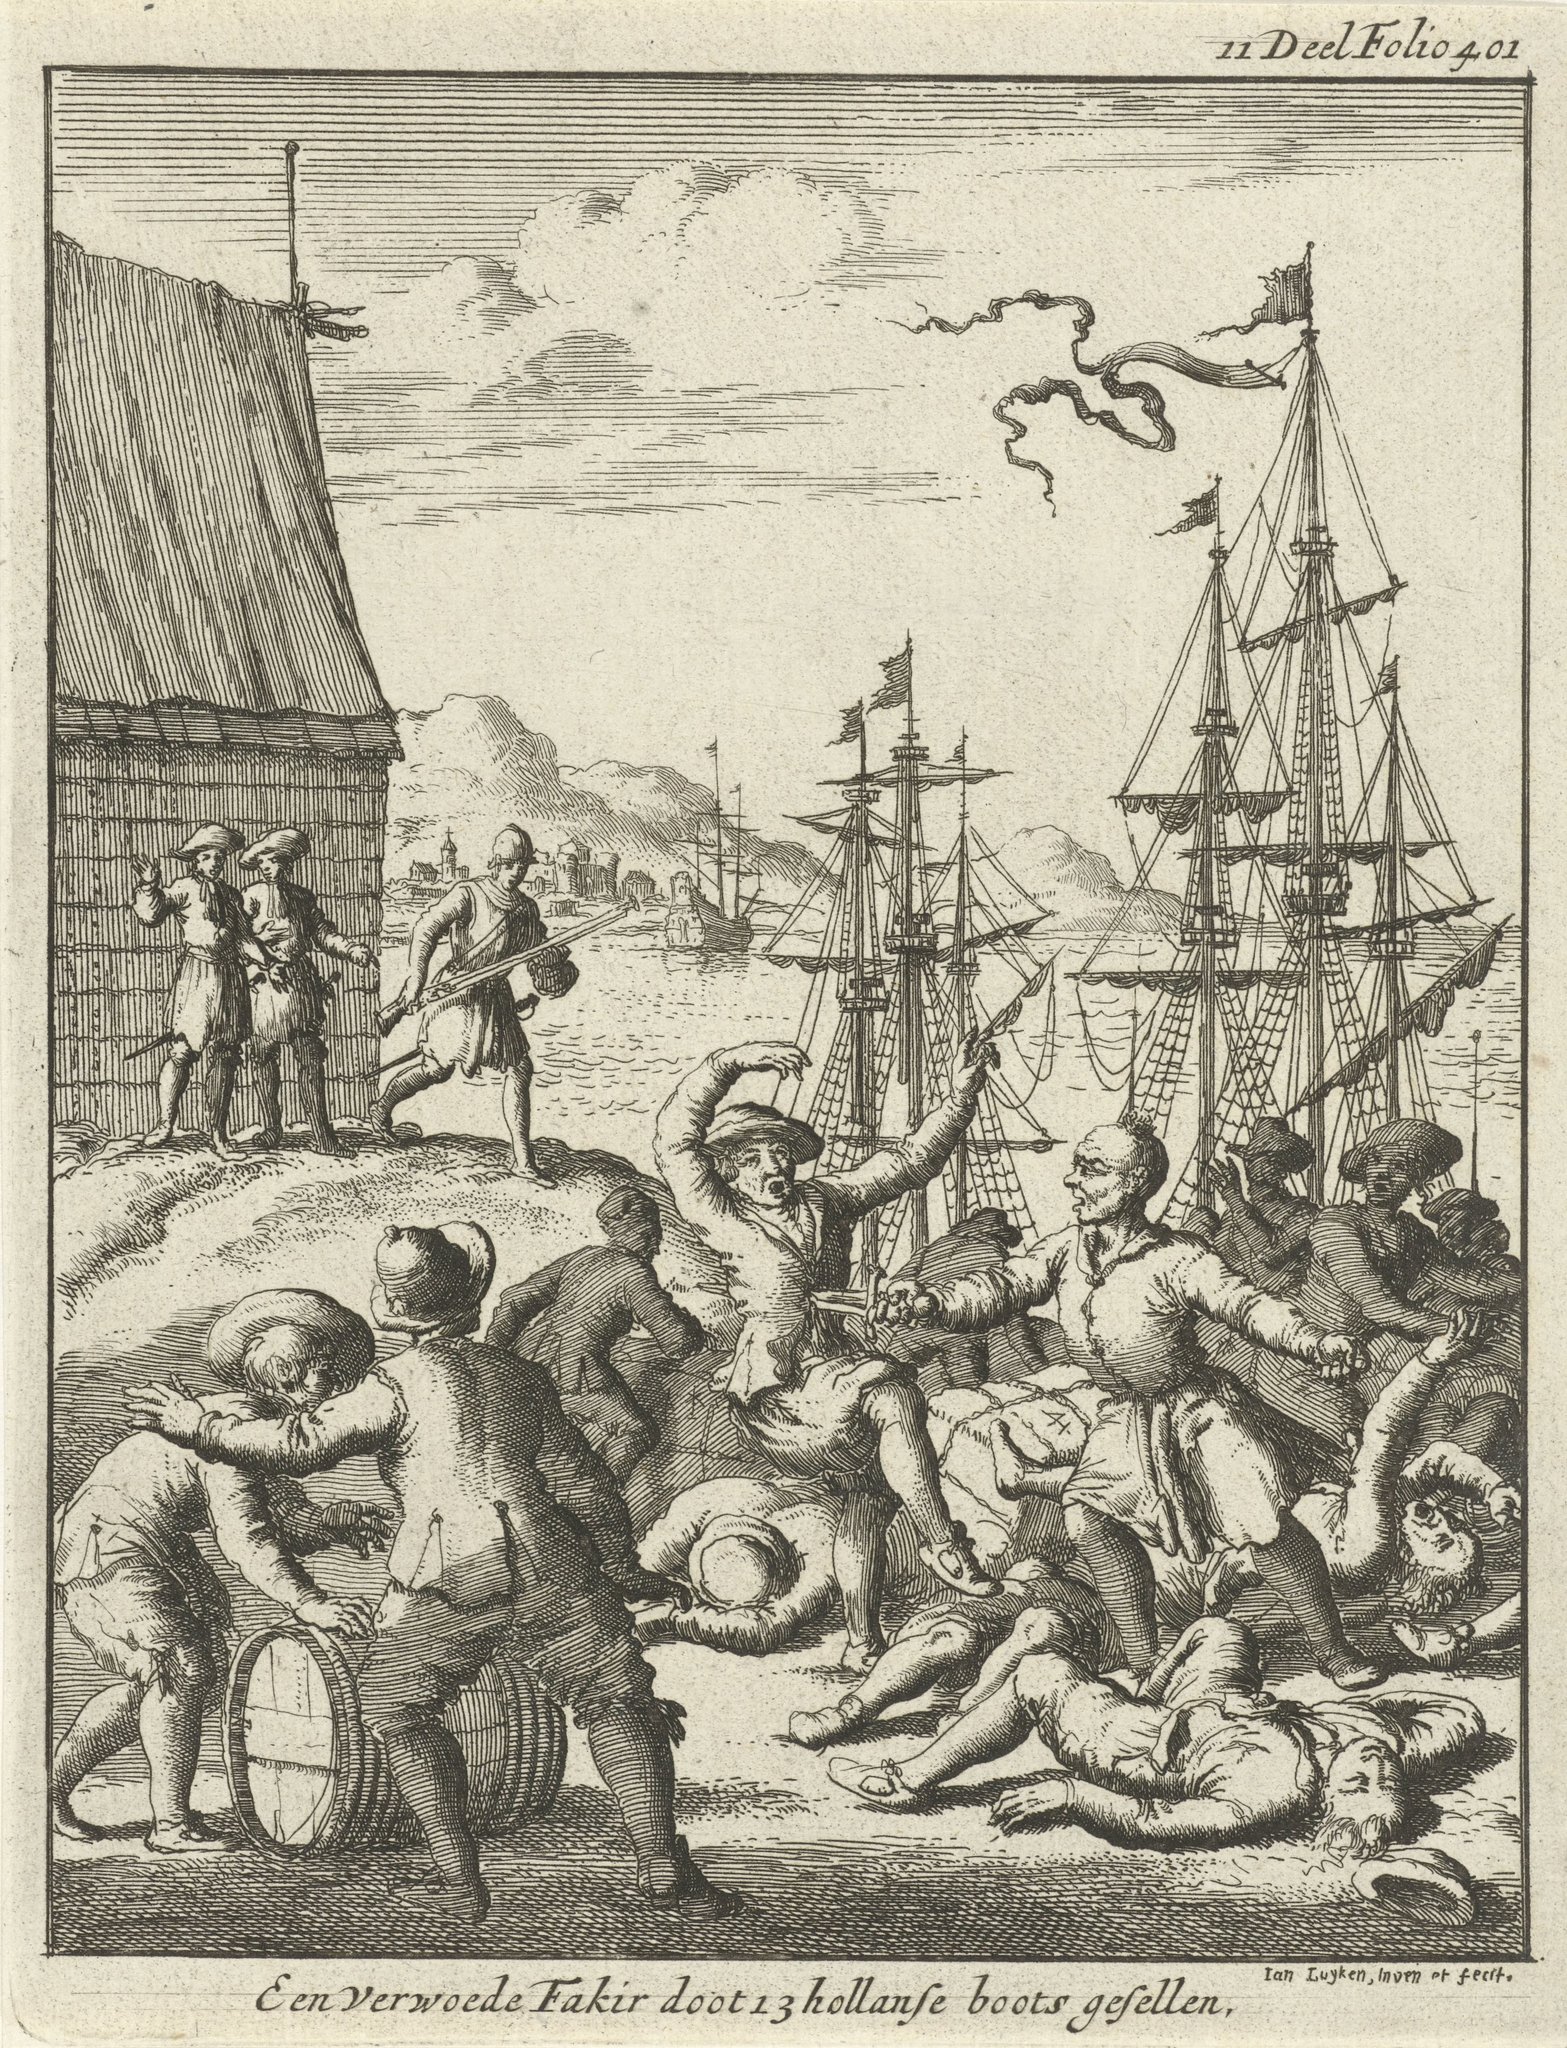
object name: print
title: Fakir valt met een mes een groep matrozen aan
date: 1682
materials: paper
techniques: etching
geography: amsterdam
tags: crew ~ ship, violent death by dagger, knife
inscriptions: collector's mark: Lugt 2228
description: Illustratie opgenomen in: Tavernier, Jean Baptiste. De Zes Reizen, 3 delen. Amsterdam: weduwe Joannes van Someren, 1682, dl. 2.